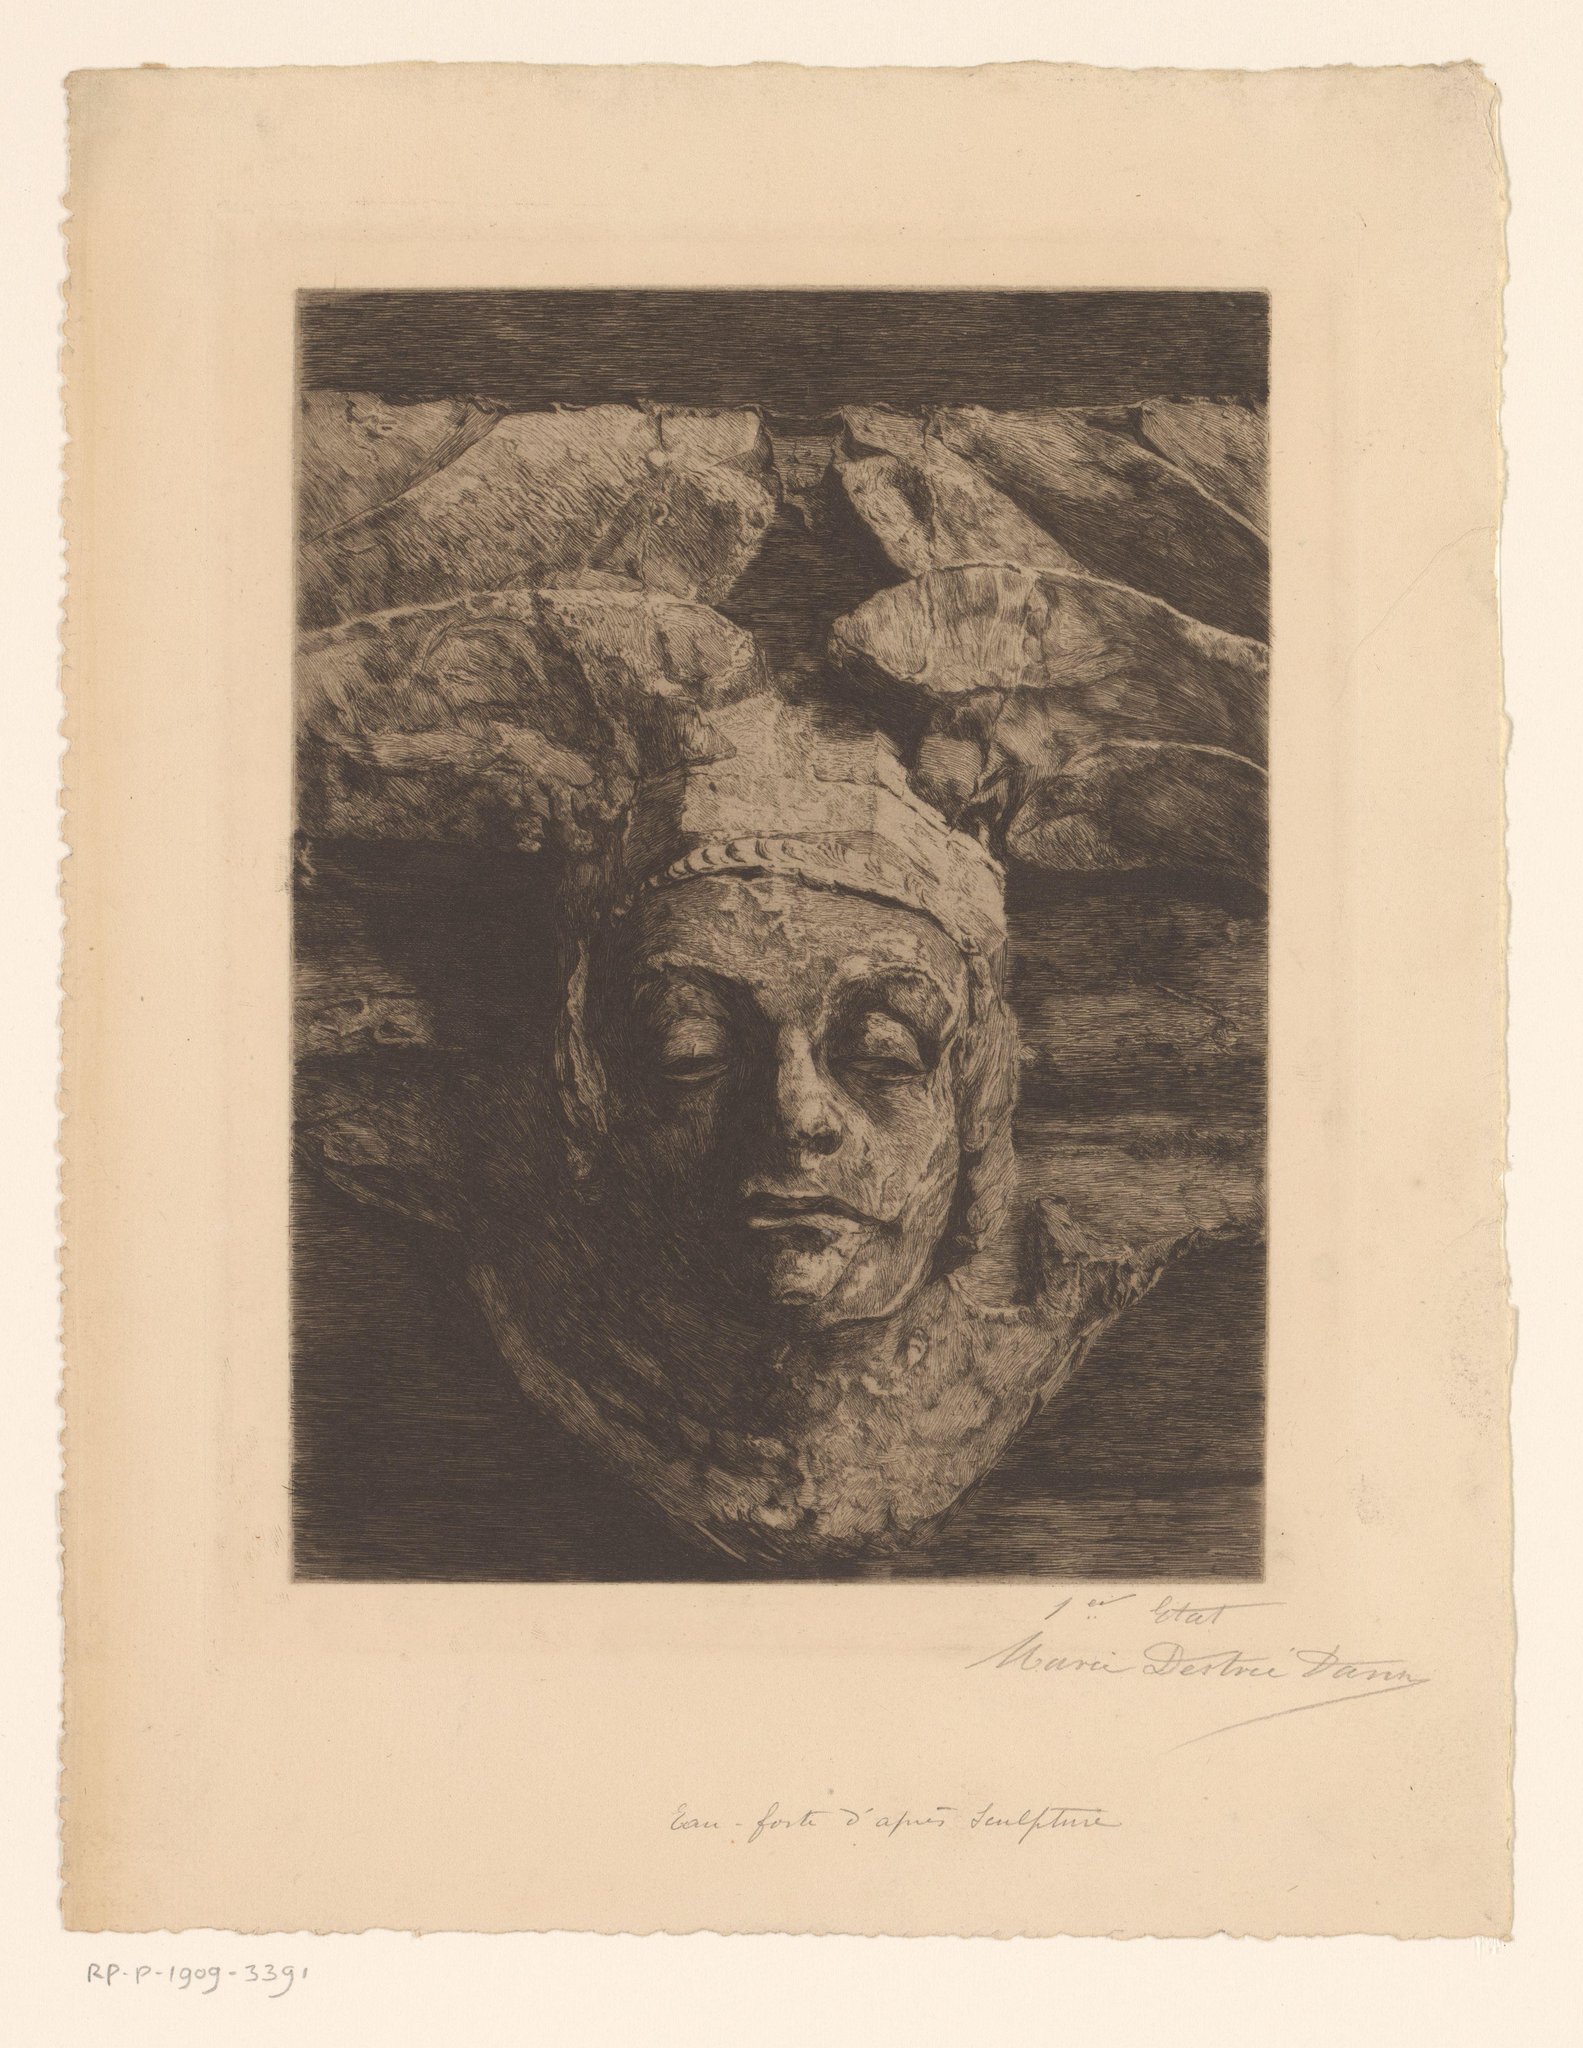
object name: print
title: Gebeeldhouwde kop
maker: marie danse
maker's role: print maker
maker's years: 1867-1942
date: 1889-1909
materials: paper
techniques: etching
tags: head (human), piece of sculpture, reproduction of a piece of sculpture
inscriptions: collector's mark: Lugt 2228, inscription: ‘1em Etat; Eau-forte d'après sculpture’